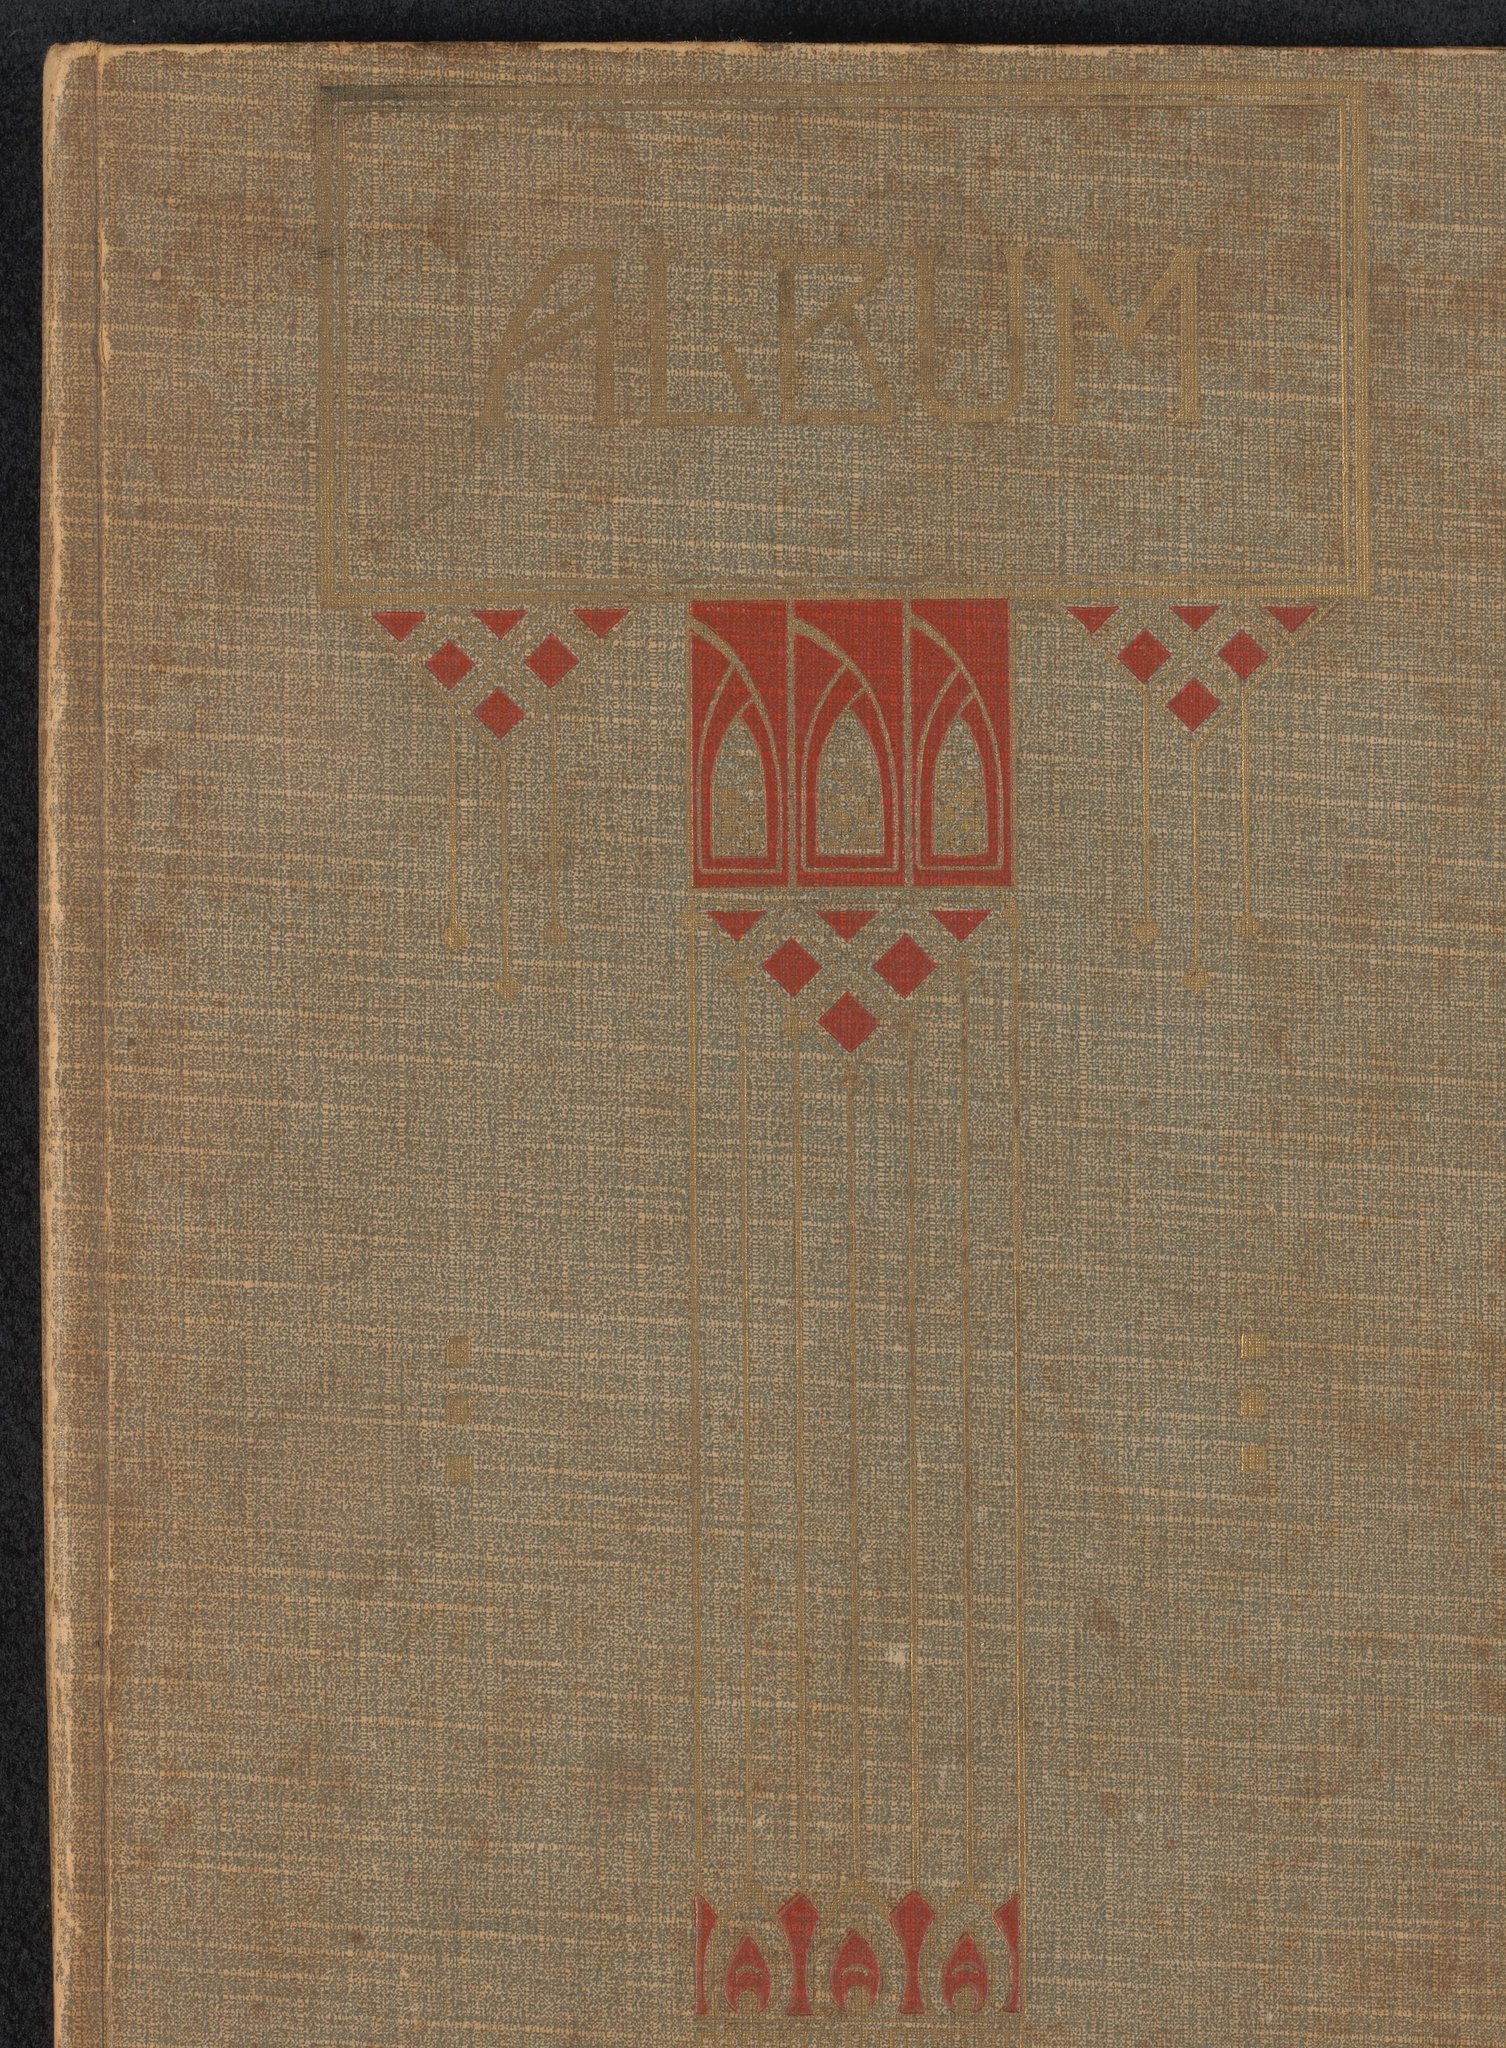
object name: photograph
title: Fotoalbum over plantages te Suriname en Curaçao, ca. 1912-1913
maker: Anonymous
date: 1912-1913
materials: cardboard, paper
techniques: gelatin silver print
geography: curacao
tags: plantation, suriname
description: Fotoalbum met 92 foto's van de plantages Peperpot en Dordrecht in Suriname en Mount Pleasant op Curaçao, ca. 1912-1913. Band van karton en papier, voorzijde met 'art nouveau-achtige' versiering in rood en goud met aanduiding 'Album' op grijs papier. Het album bevat 24 bladen waarin op elke zijde twee foto's (geplakt op briefkaarten) zijn in gestoken. Bij de foto's handgeschreven notities.